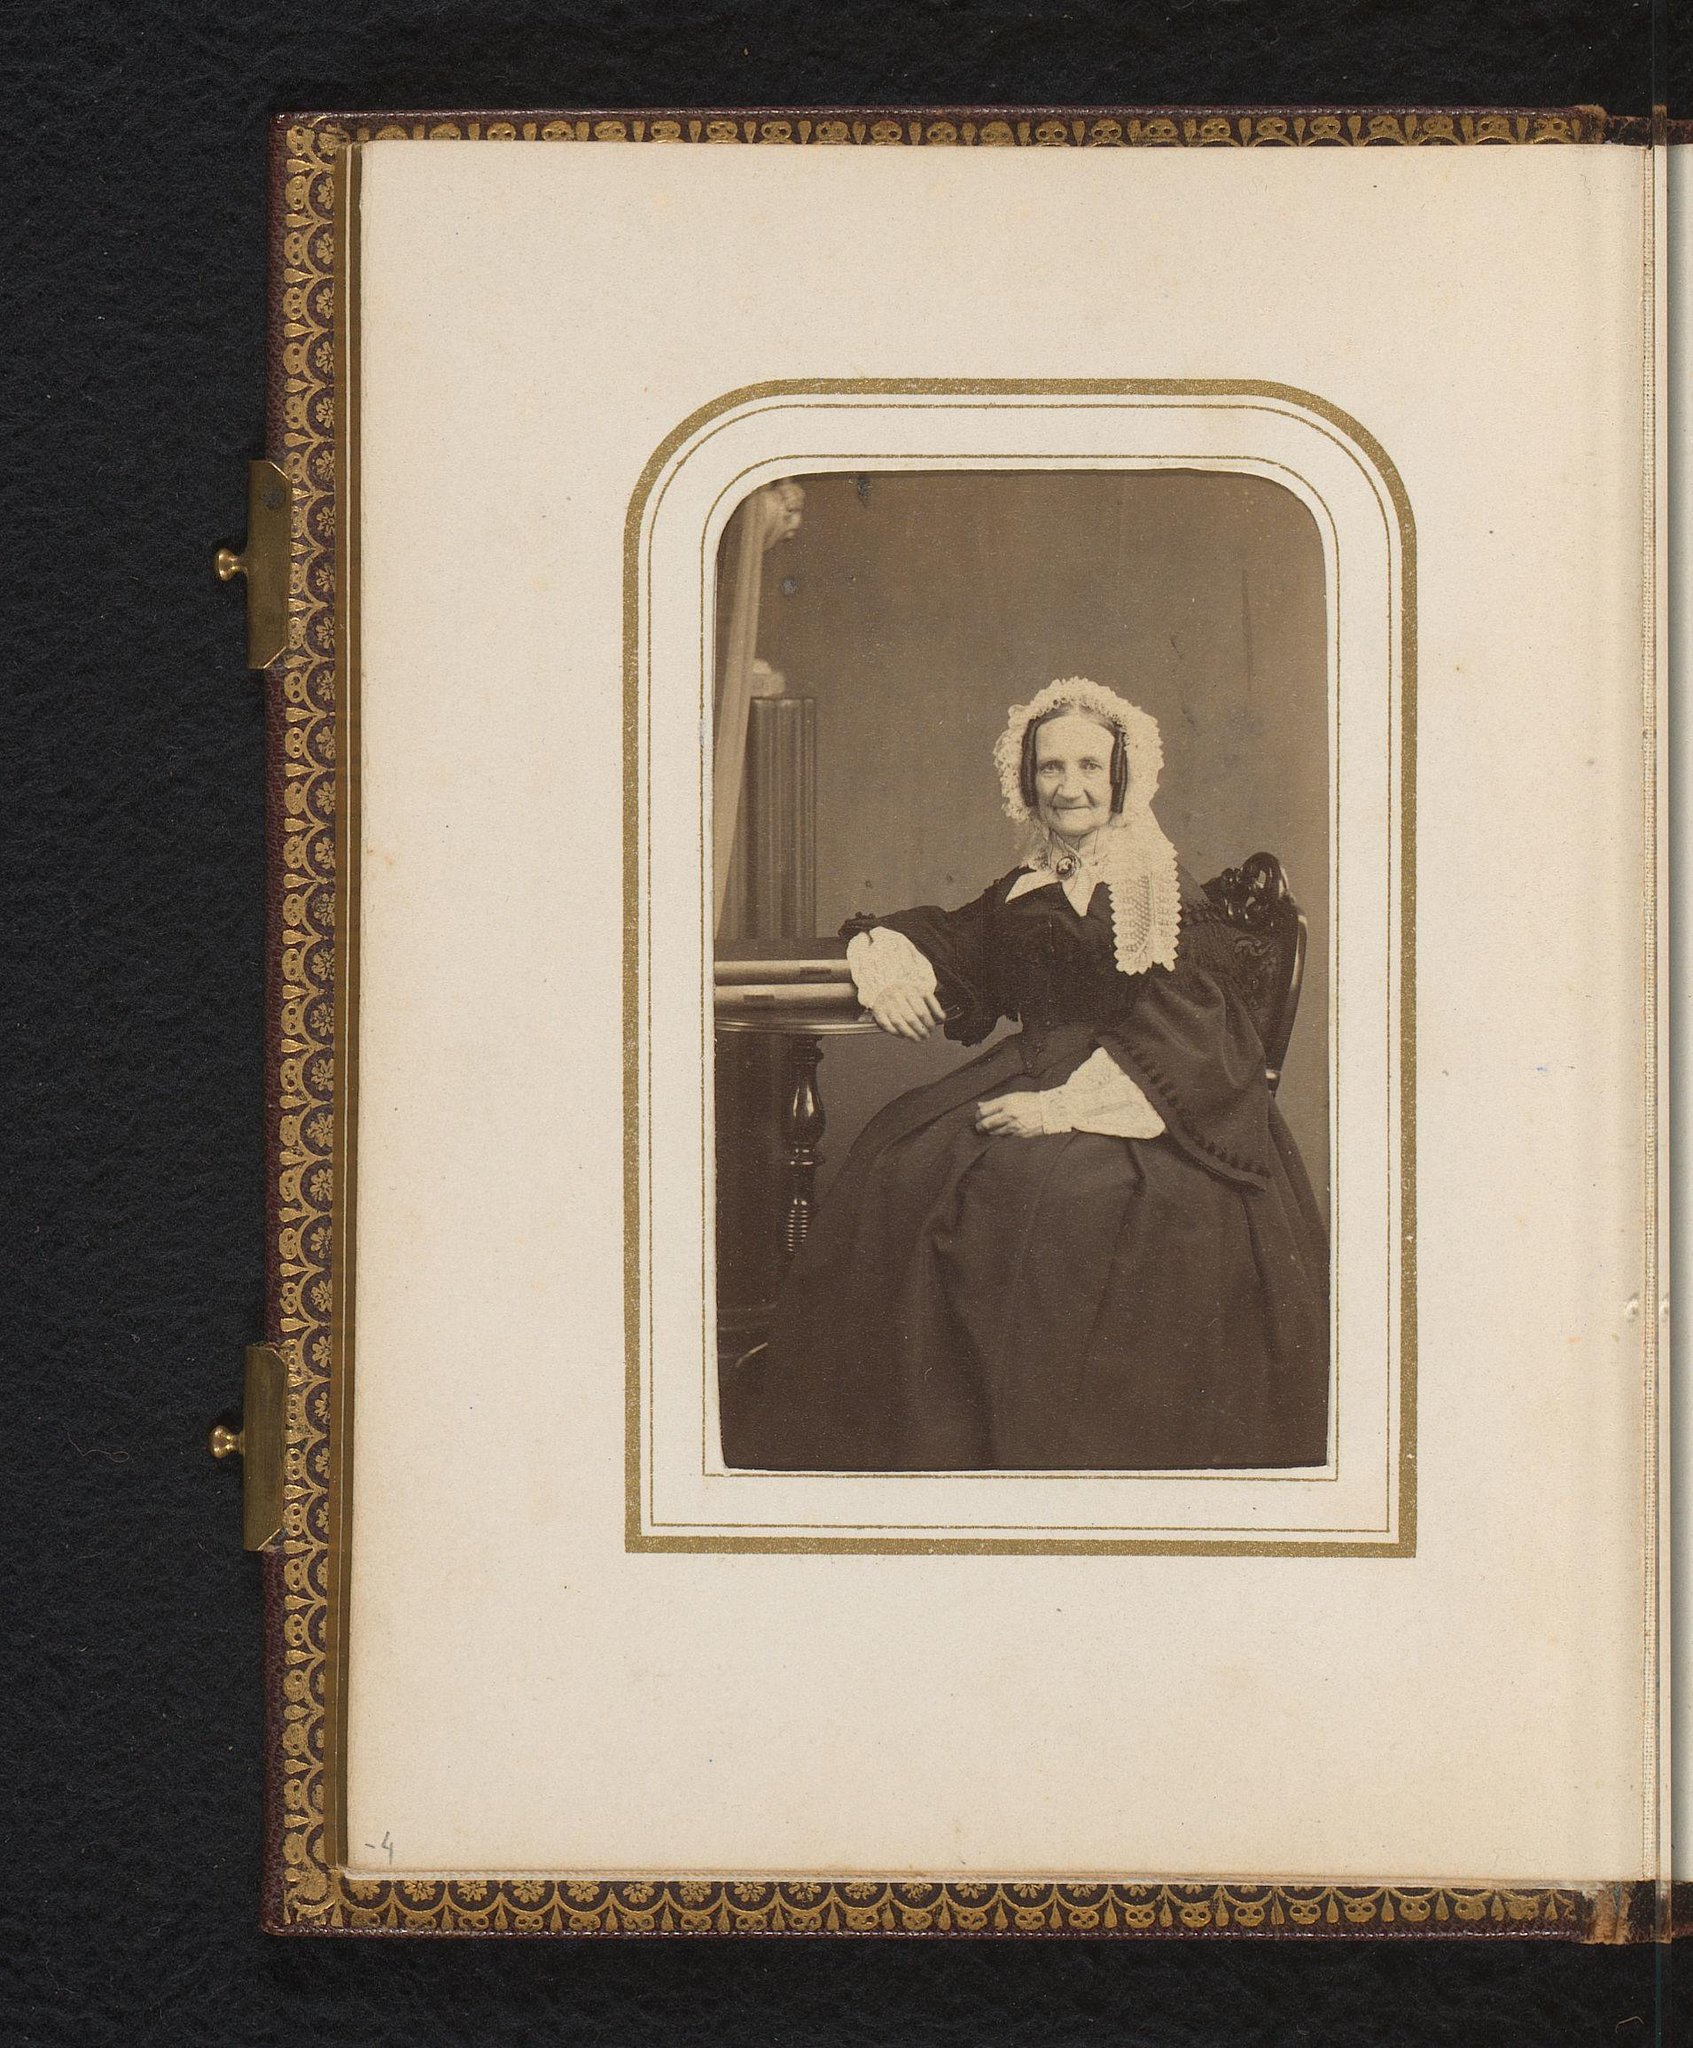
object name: carte de visite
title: Portret van een onbekende vrouw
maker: Anonymous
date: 1860-1870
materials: cardboard, paper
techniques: albumen print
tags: anonymous historical person portrayed - bb - woman